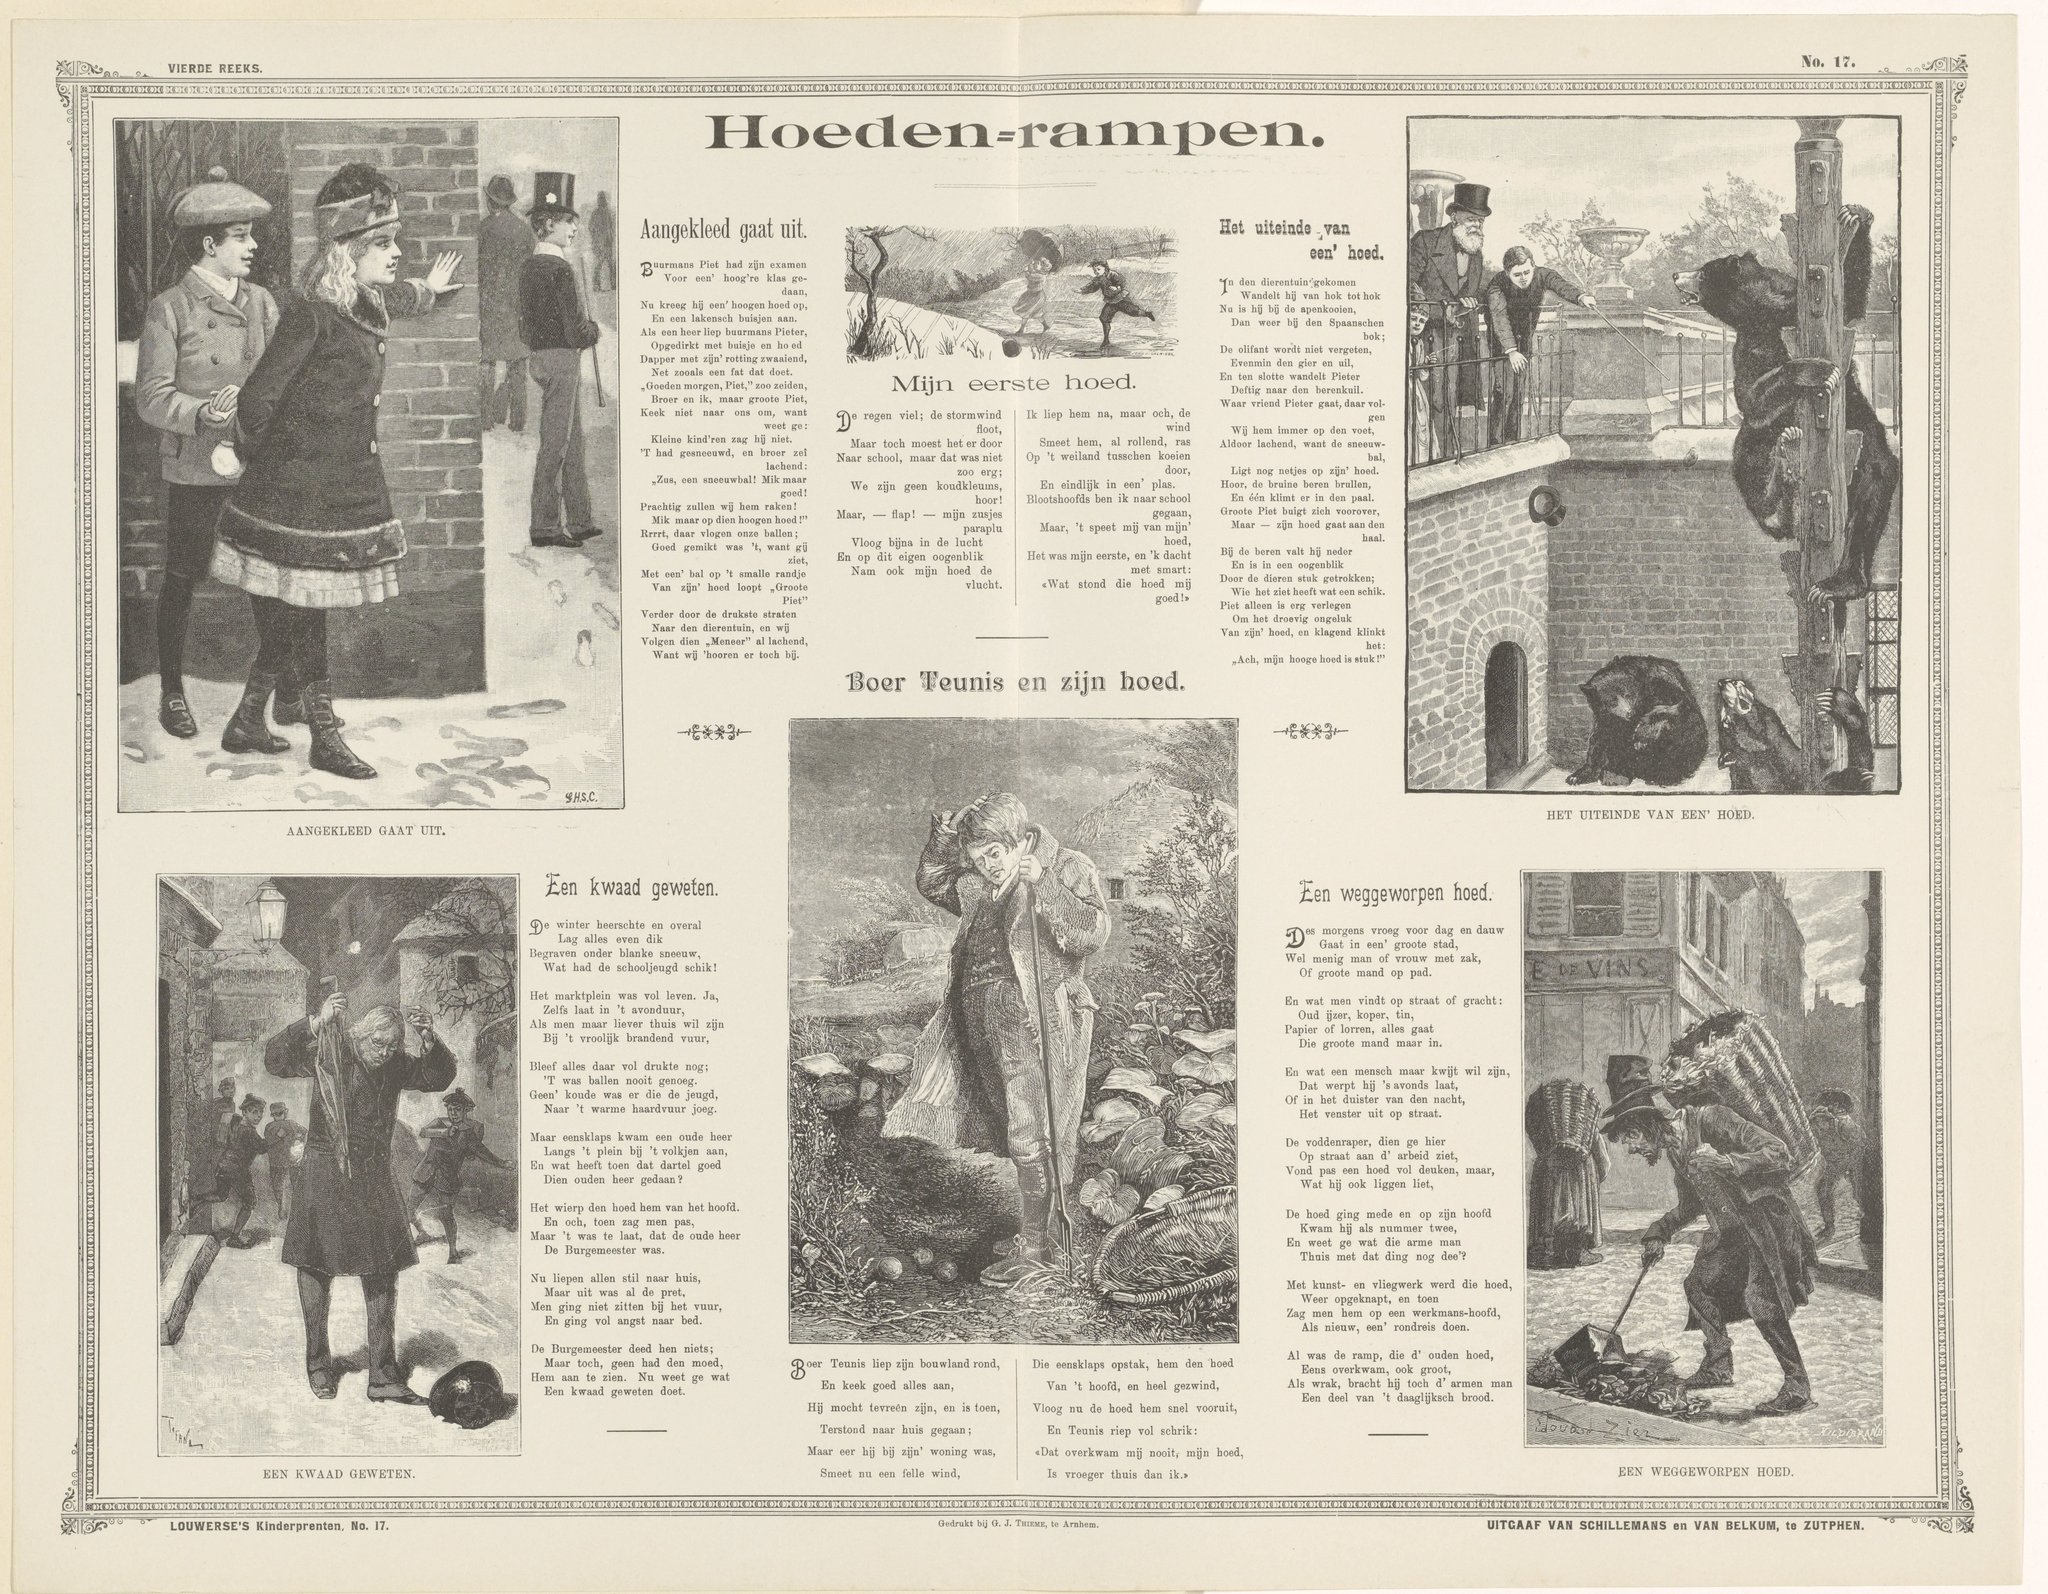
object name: print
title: Vierde reeks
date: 1905-1924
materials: paper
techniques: letterpress printing, printing block, engraving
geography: zutphen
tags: head-gear: hat, head-gear: top hat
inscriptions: collector's mark: Lugt 2760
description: Blad met 6 voorstellingen van mensen die hun hoed laten vallen, of waarvan de hoed vies wordt. Tussen de afbeeldingen versjes in boekdruk. Genummerd rechtsboven en linksonder: No. 17.